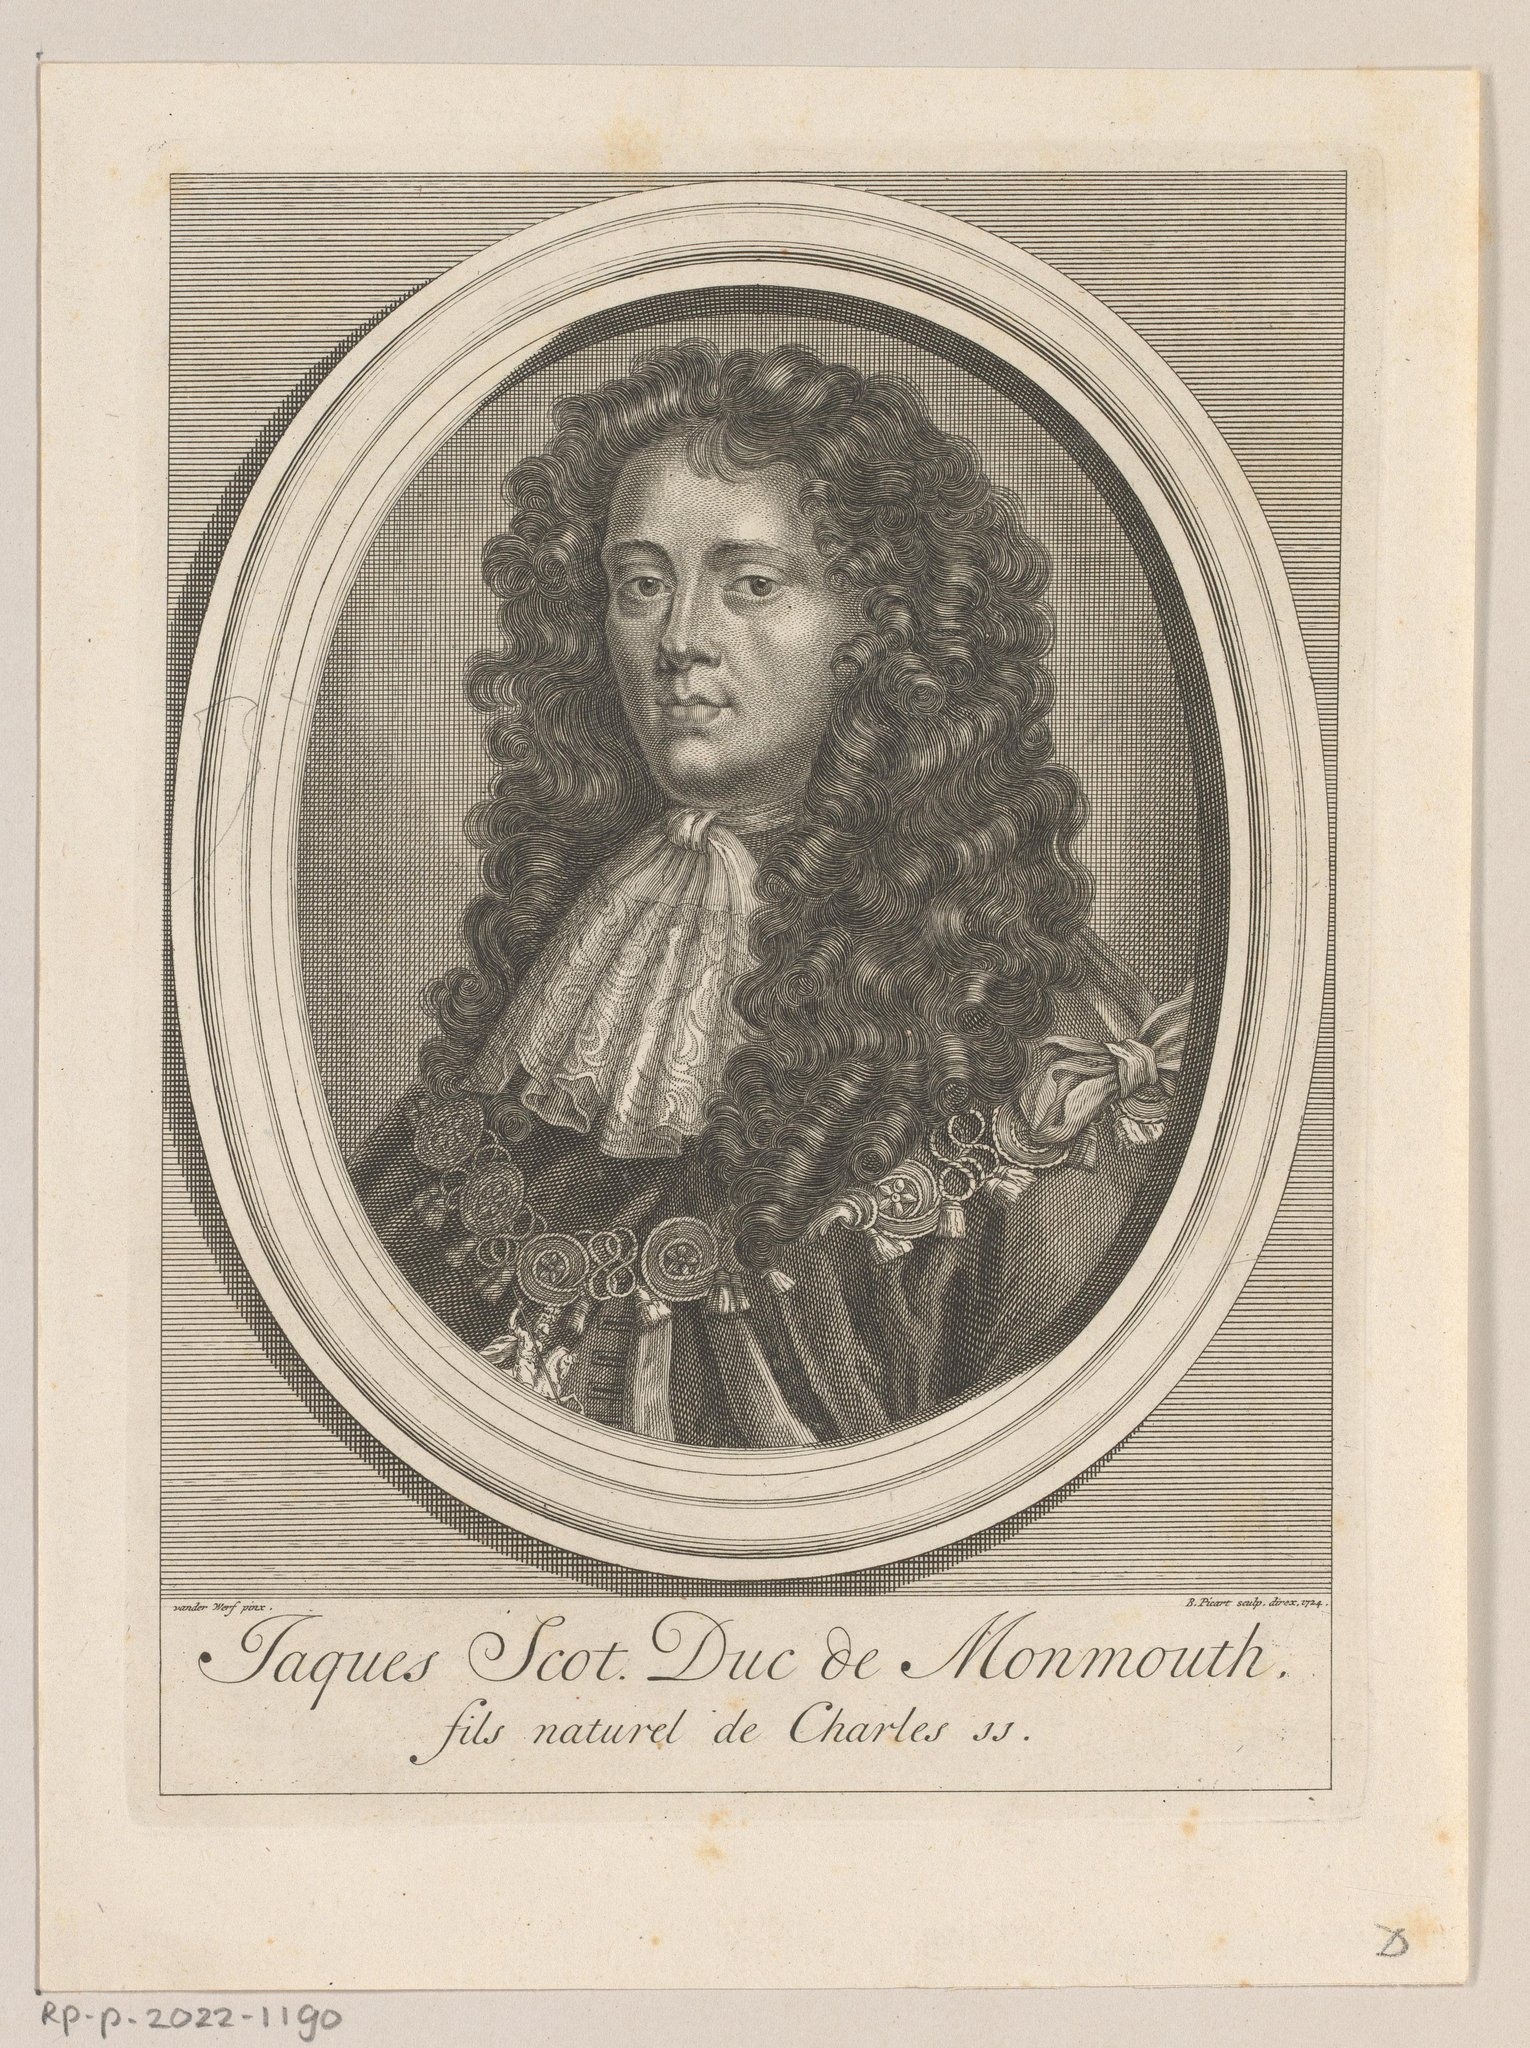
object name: print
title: Portret van James Scott hertog van Monmouth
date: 1724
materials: paper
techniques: engraving, etching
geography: amsterdam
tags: knighthood order, historical persons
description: Prent waarschijnlijk uit: Burnet, Gilbert. Histoire des dernières révolutions d'Angleterre. Den Haag: Jean Neaulme, 1725.